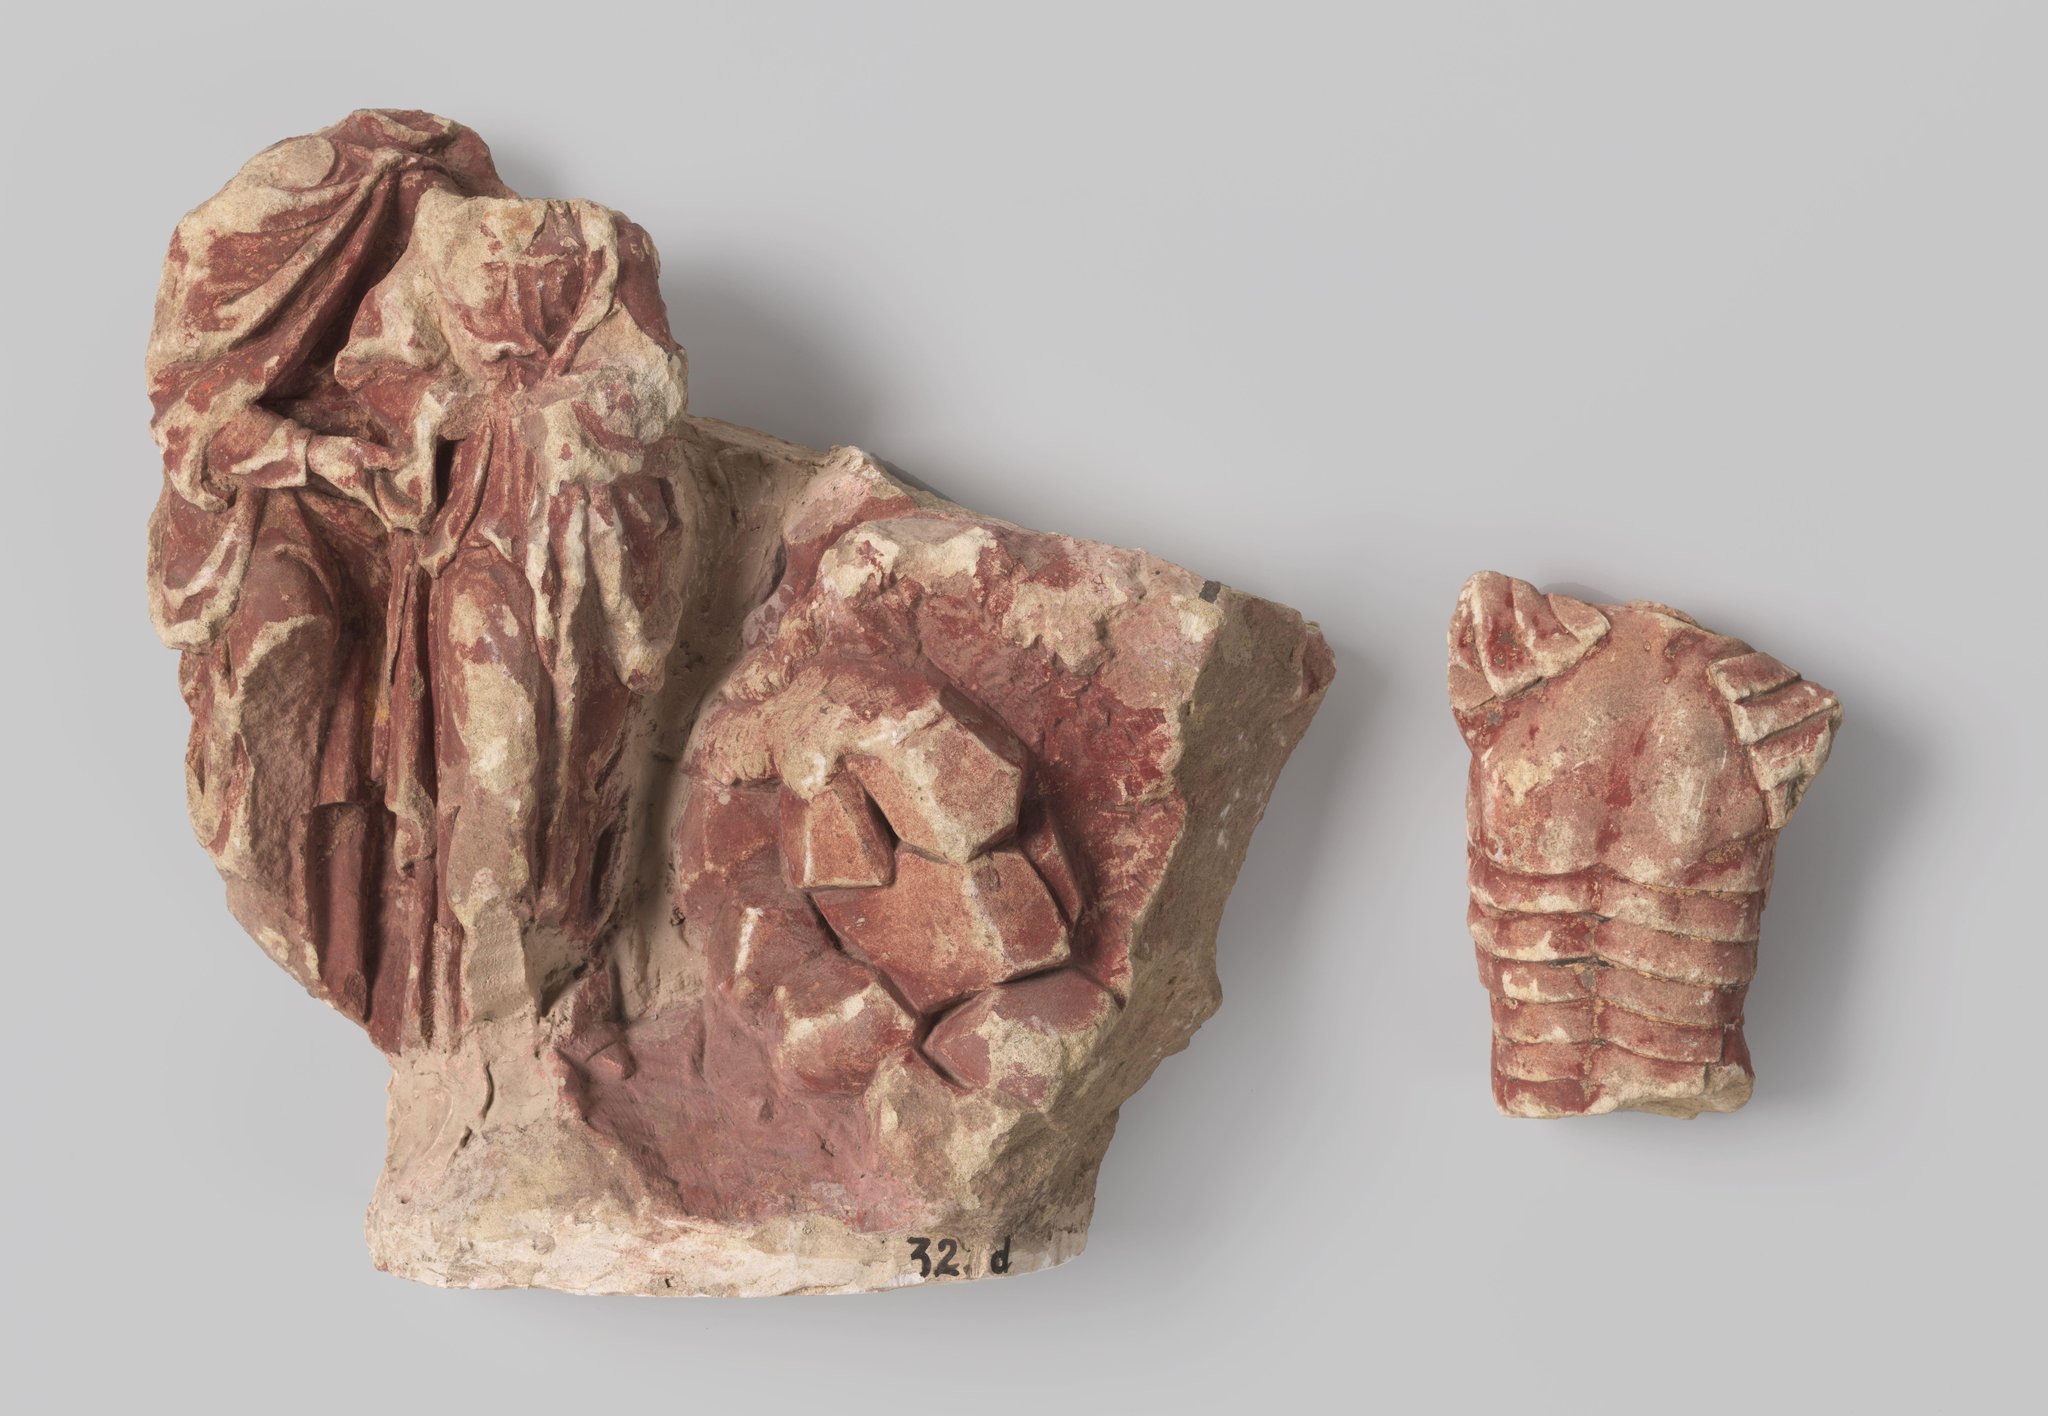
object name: epitaaf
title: Epitaaf, voorstellende de Kruisiging, opgegraven te Utrecht bij het oude Minderbroederklooster (fragmenten)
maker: Anonymous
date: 1500-1525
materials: stone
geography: utrecht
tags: minderbroedersklooster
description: Dertien fragmenten van een beeldgroep die waarschijnlijk in het epitaaf gestaan heeft. Donkerrood gekleurd. De groep moet een kruisiging hebben voorgesteld. Het grootste fragment stelt voor Johannes Maria wegleidende, rechts hiervan op de achtergrond krijgslieden te paard. Opgegraven te Utrecht bij het oude Minderbroederklooster.